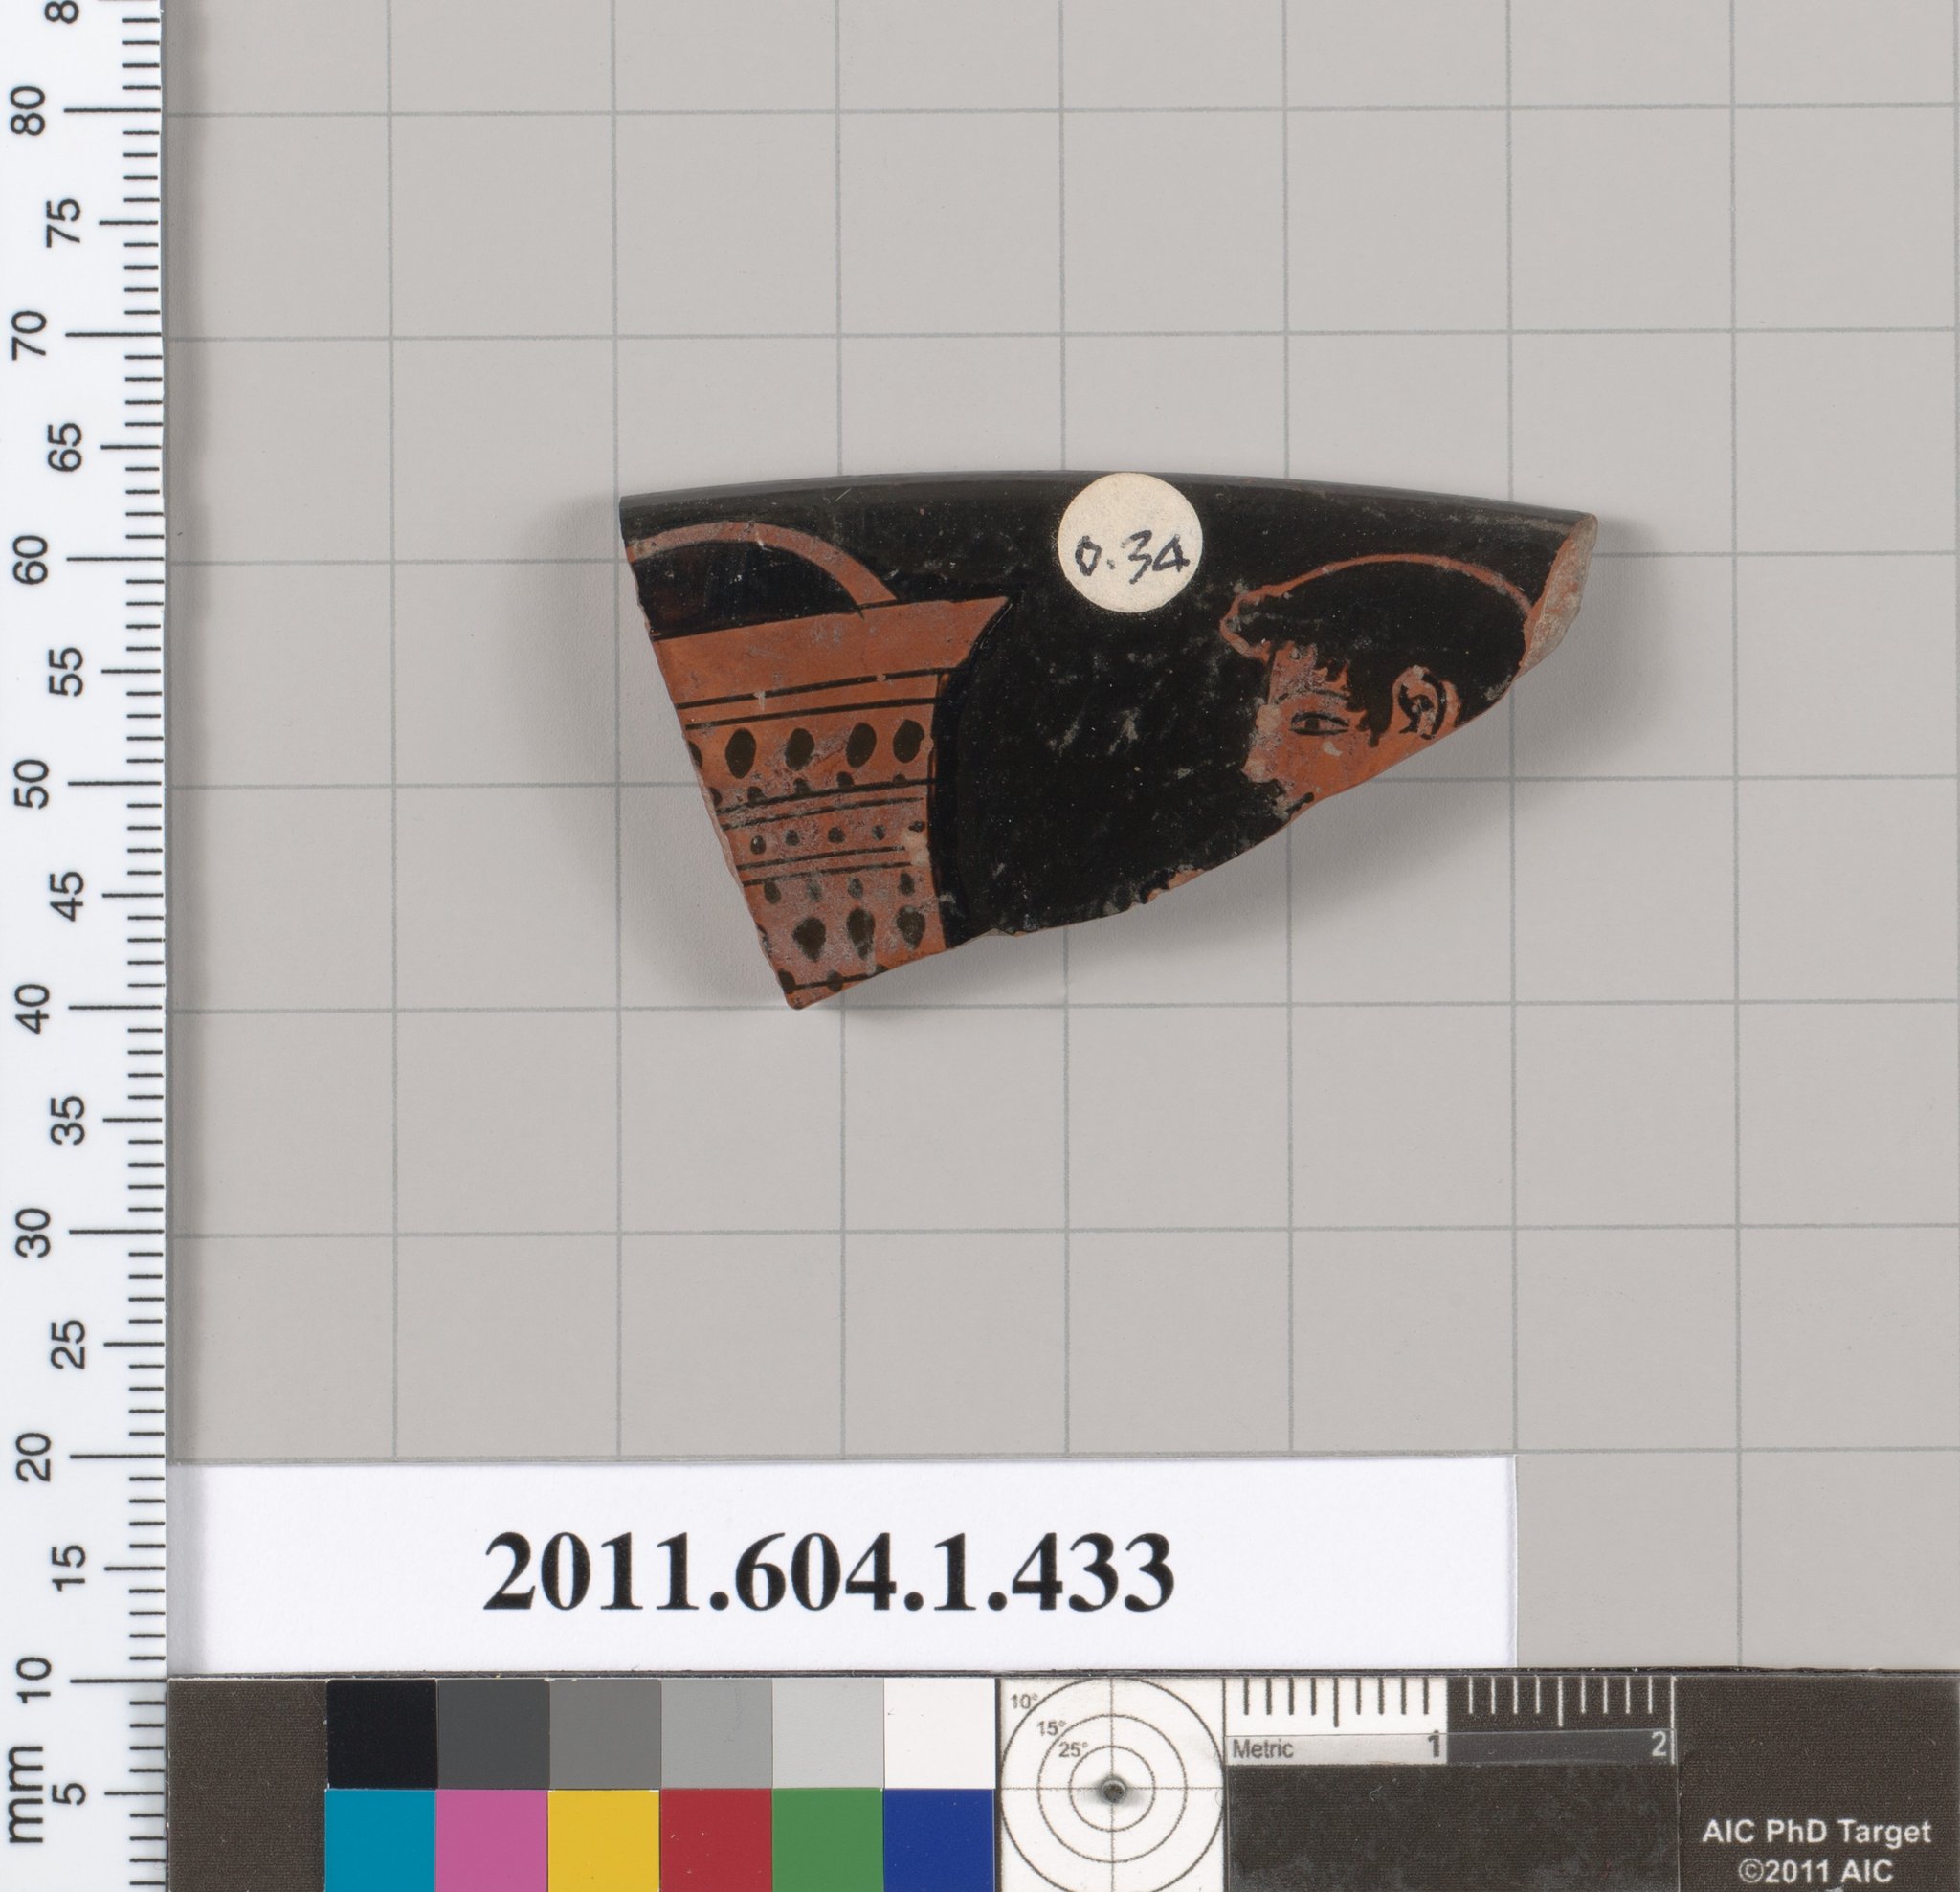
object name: kylix fragment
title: Terracotta rim fragment of a kylix (drinking cup)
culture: greek, attic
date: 475-451 BCE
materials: terracotta